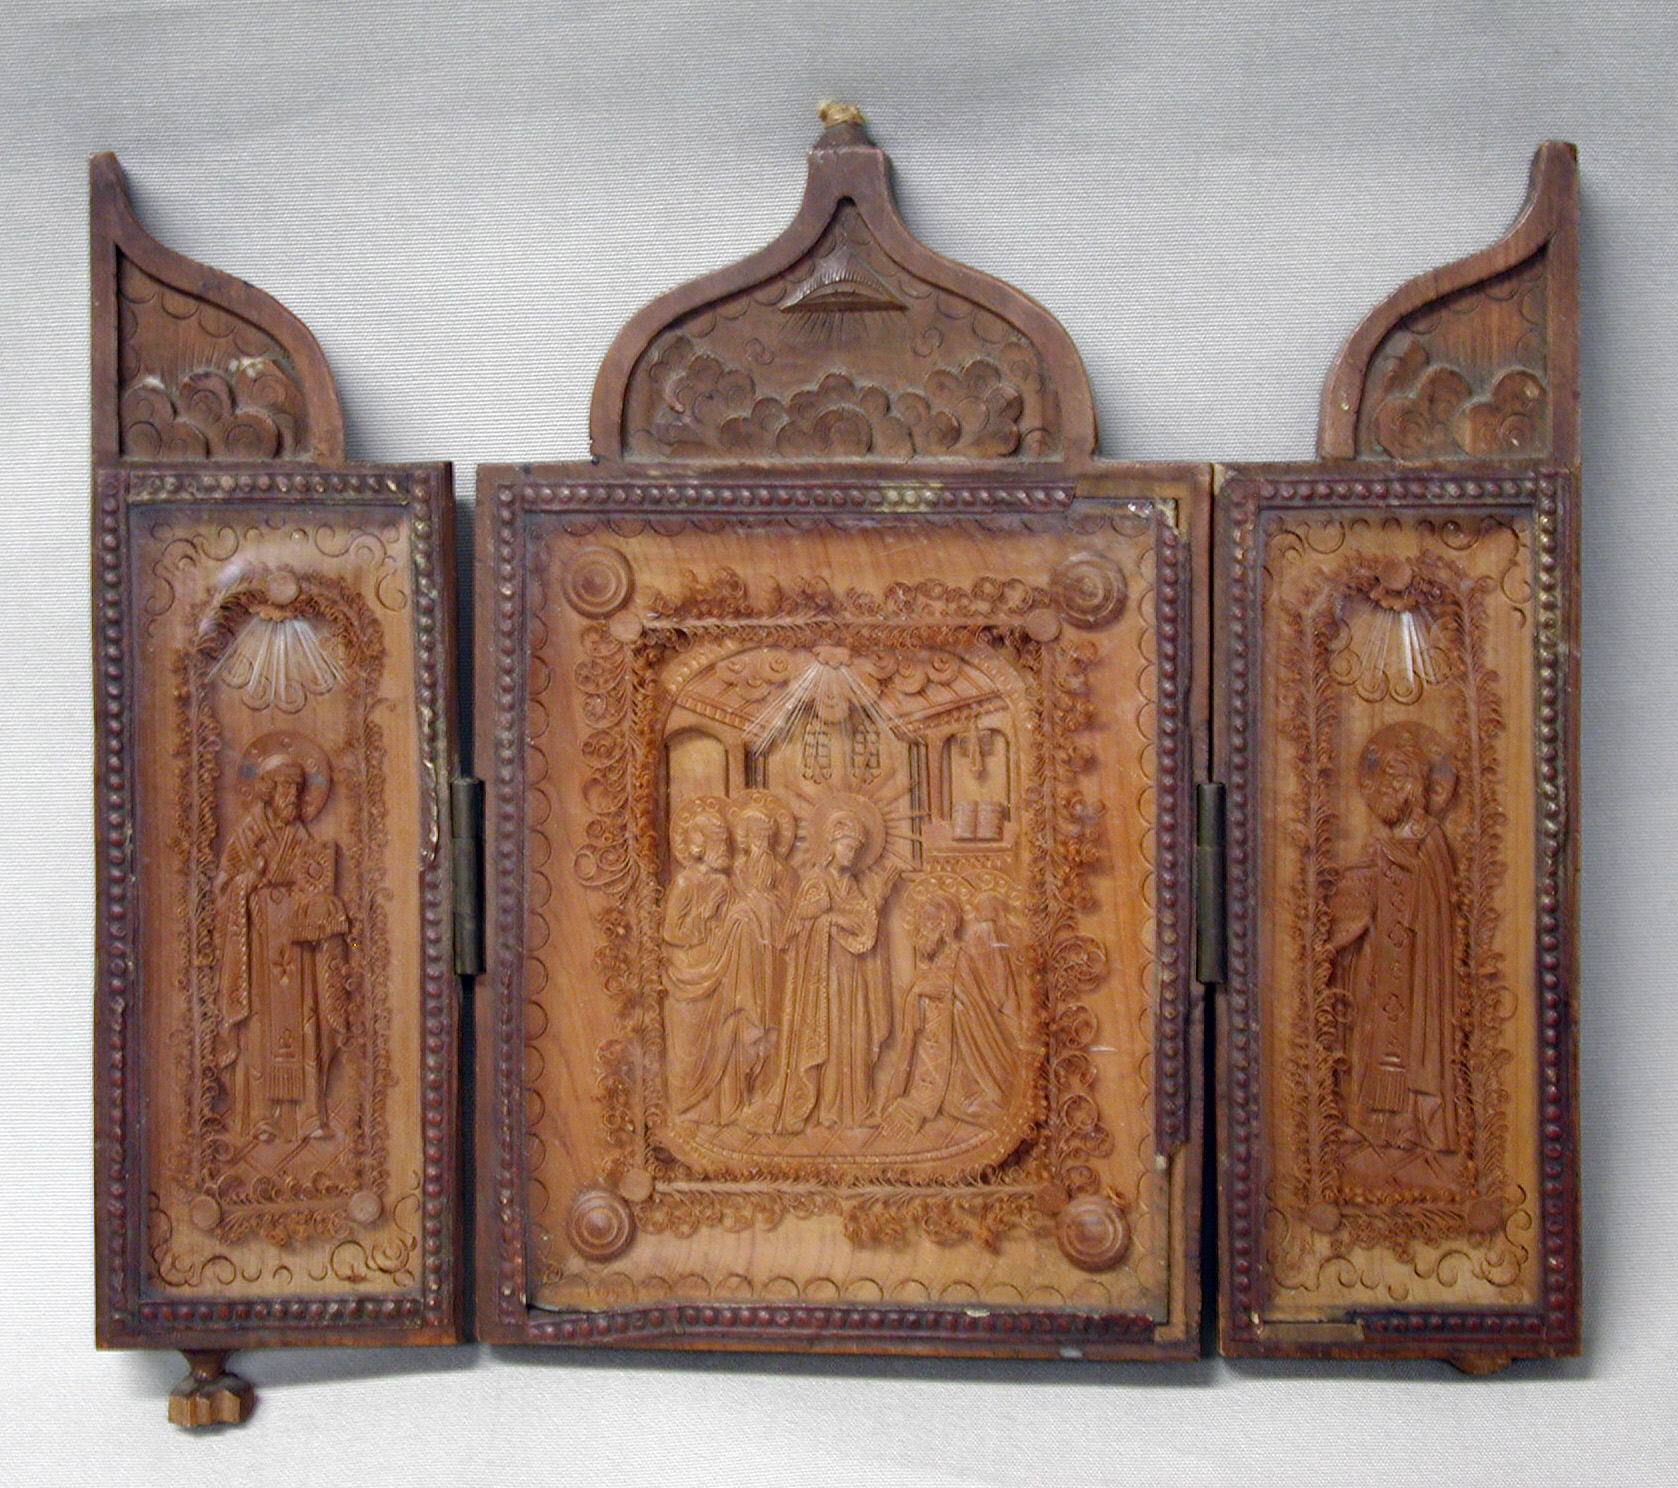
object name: triptych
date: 1700-1725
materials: wood, glass, hair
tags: virgin mary,saints